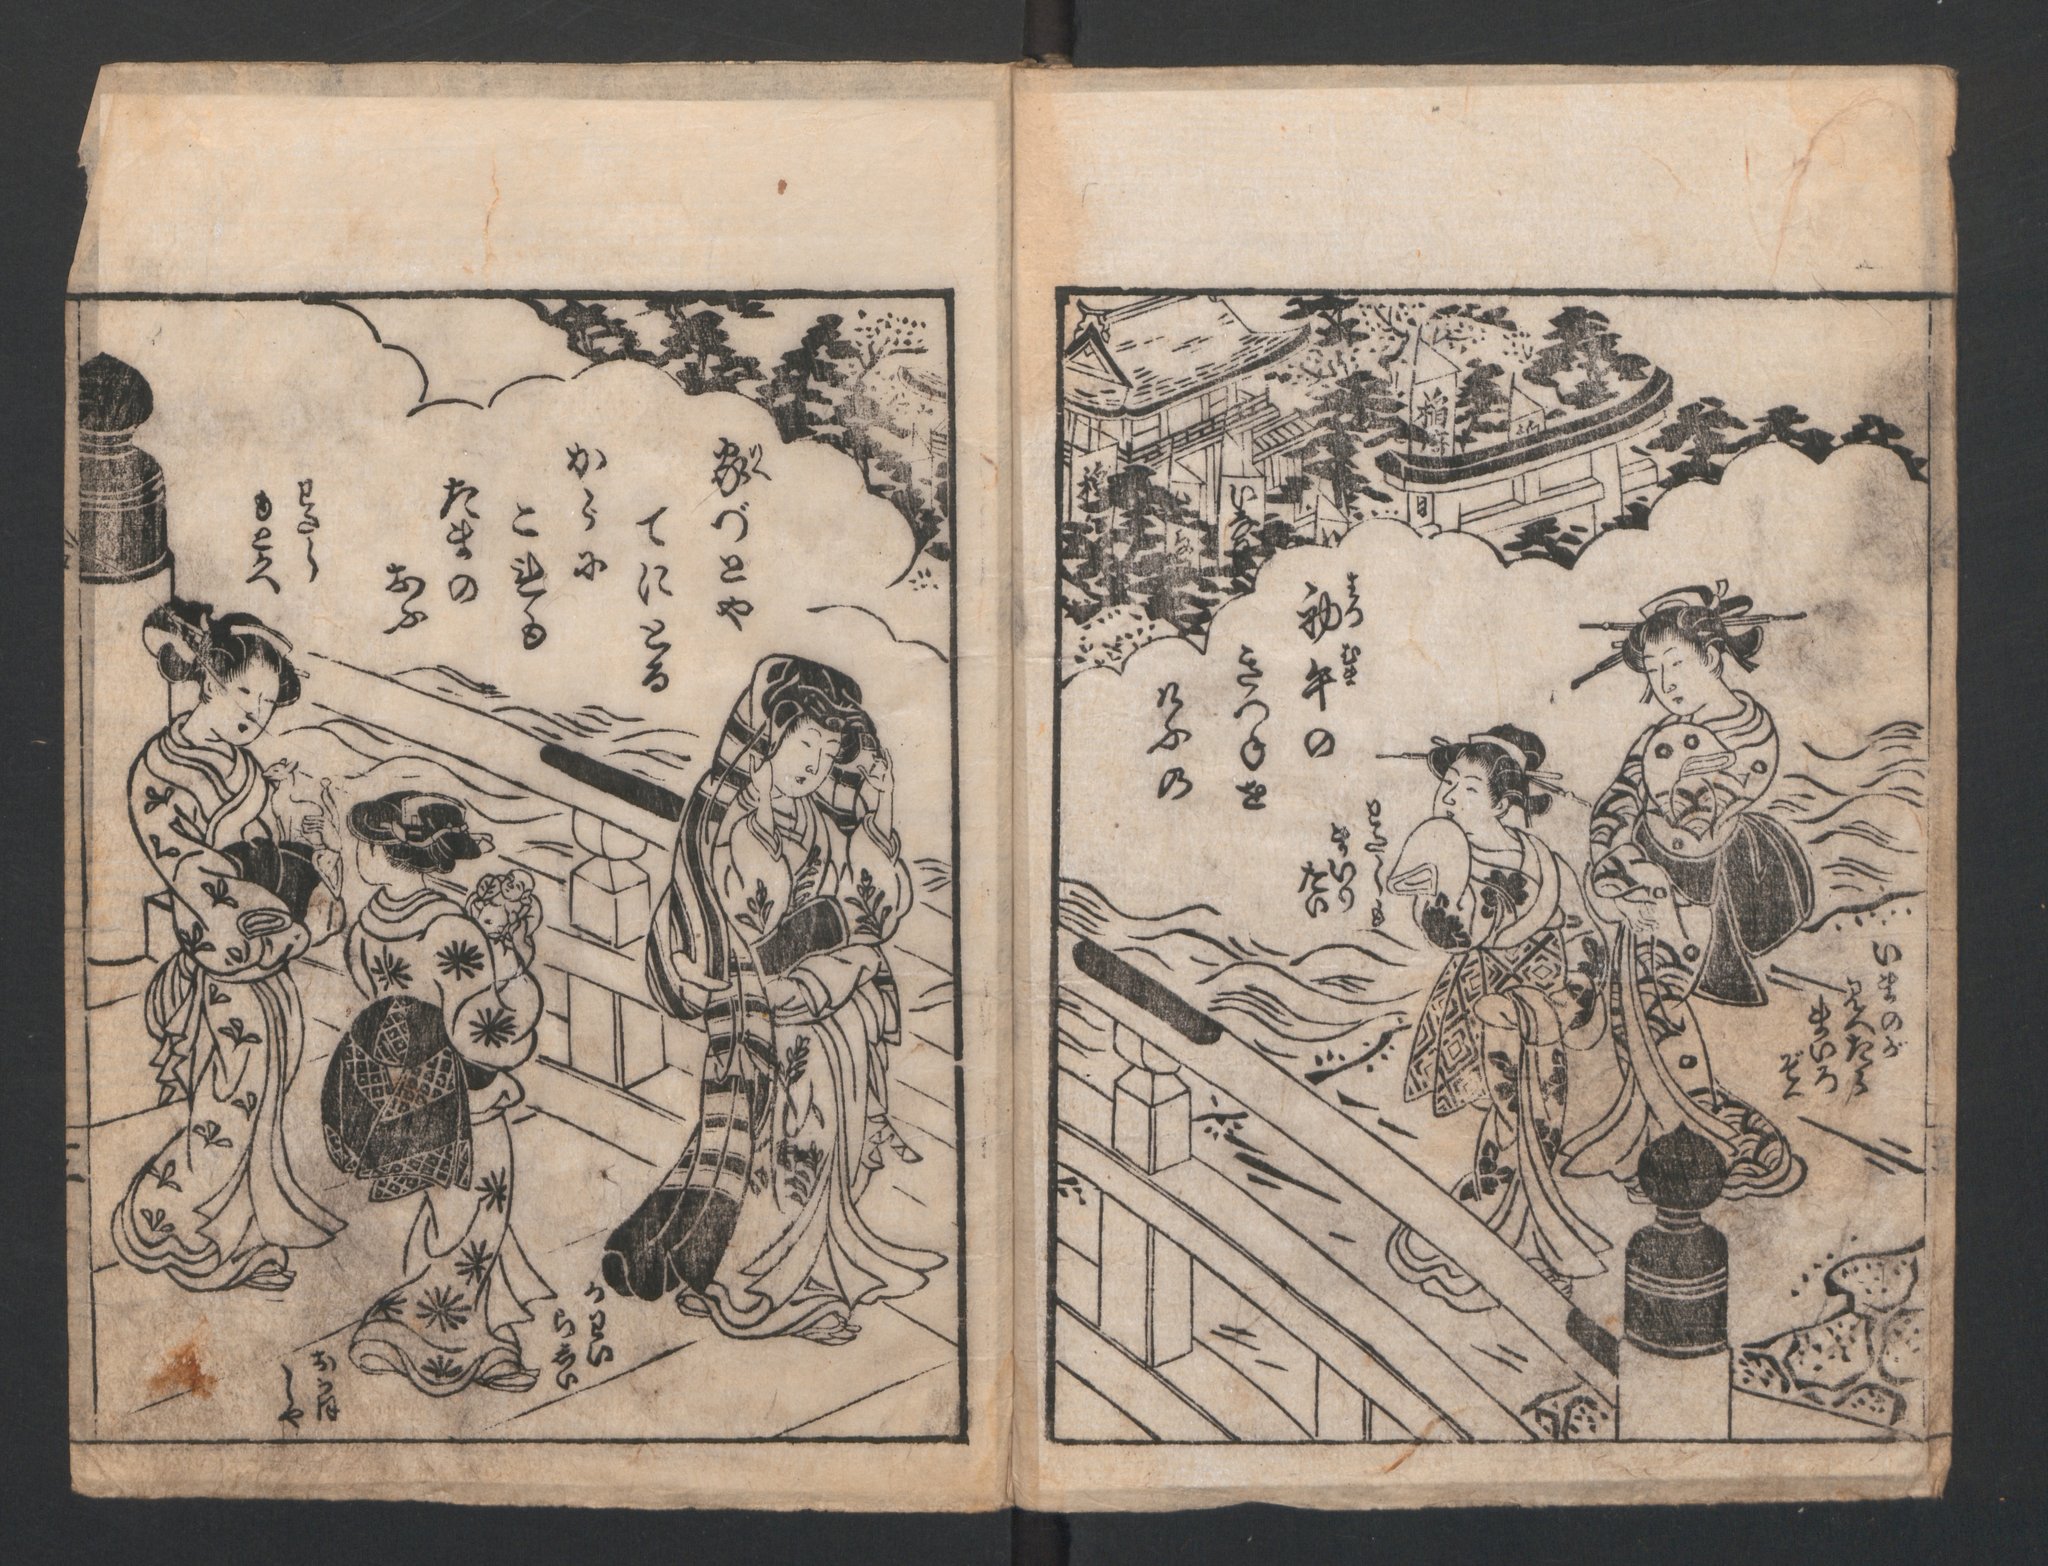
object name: illustrated book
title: The Style of Woman's Fashion (Jochū ehon fūzoku yō) 女中絵本風俗容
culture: japanese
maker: terasawa masatsugu 寺沢昌次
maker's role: artist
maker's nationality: japanese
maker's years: -1790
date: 1615-1868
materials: ink, paper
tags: men,women,tea drinking,boats,eating